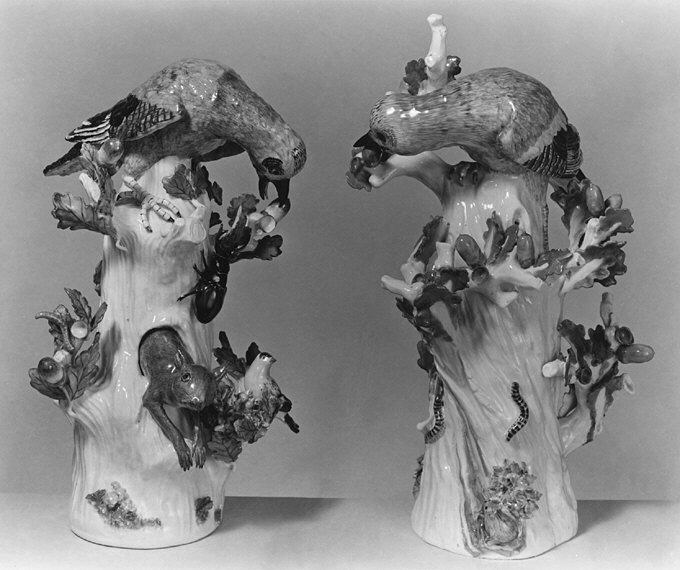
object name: figure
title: Jay (one of a pair)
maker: meissen manufactory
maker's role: manufactory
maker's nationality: german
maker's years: 1710-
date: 1740-1745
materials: hard paste porcelain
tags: animals,birds